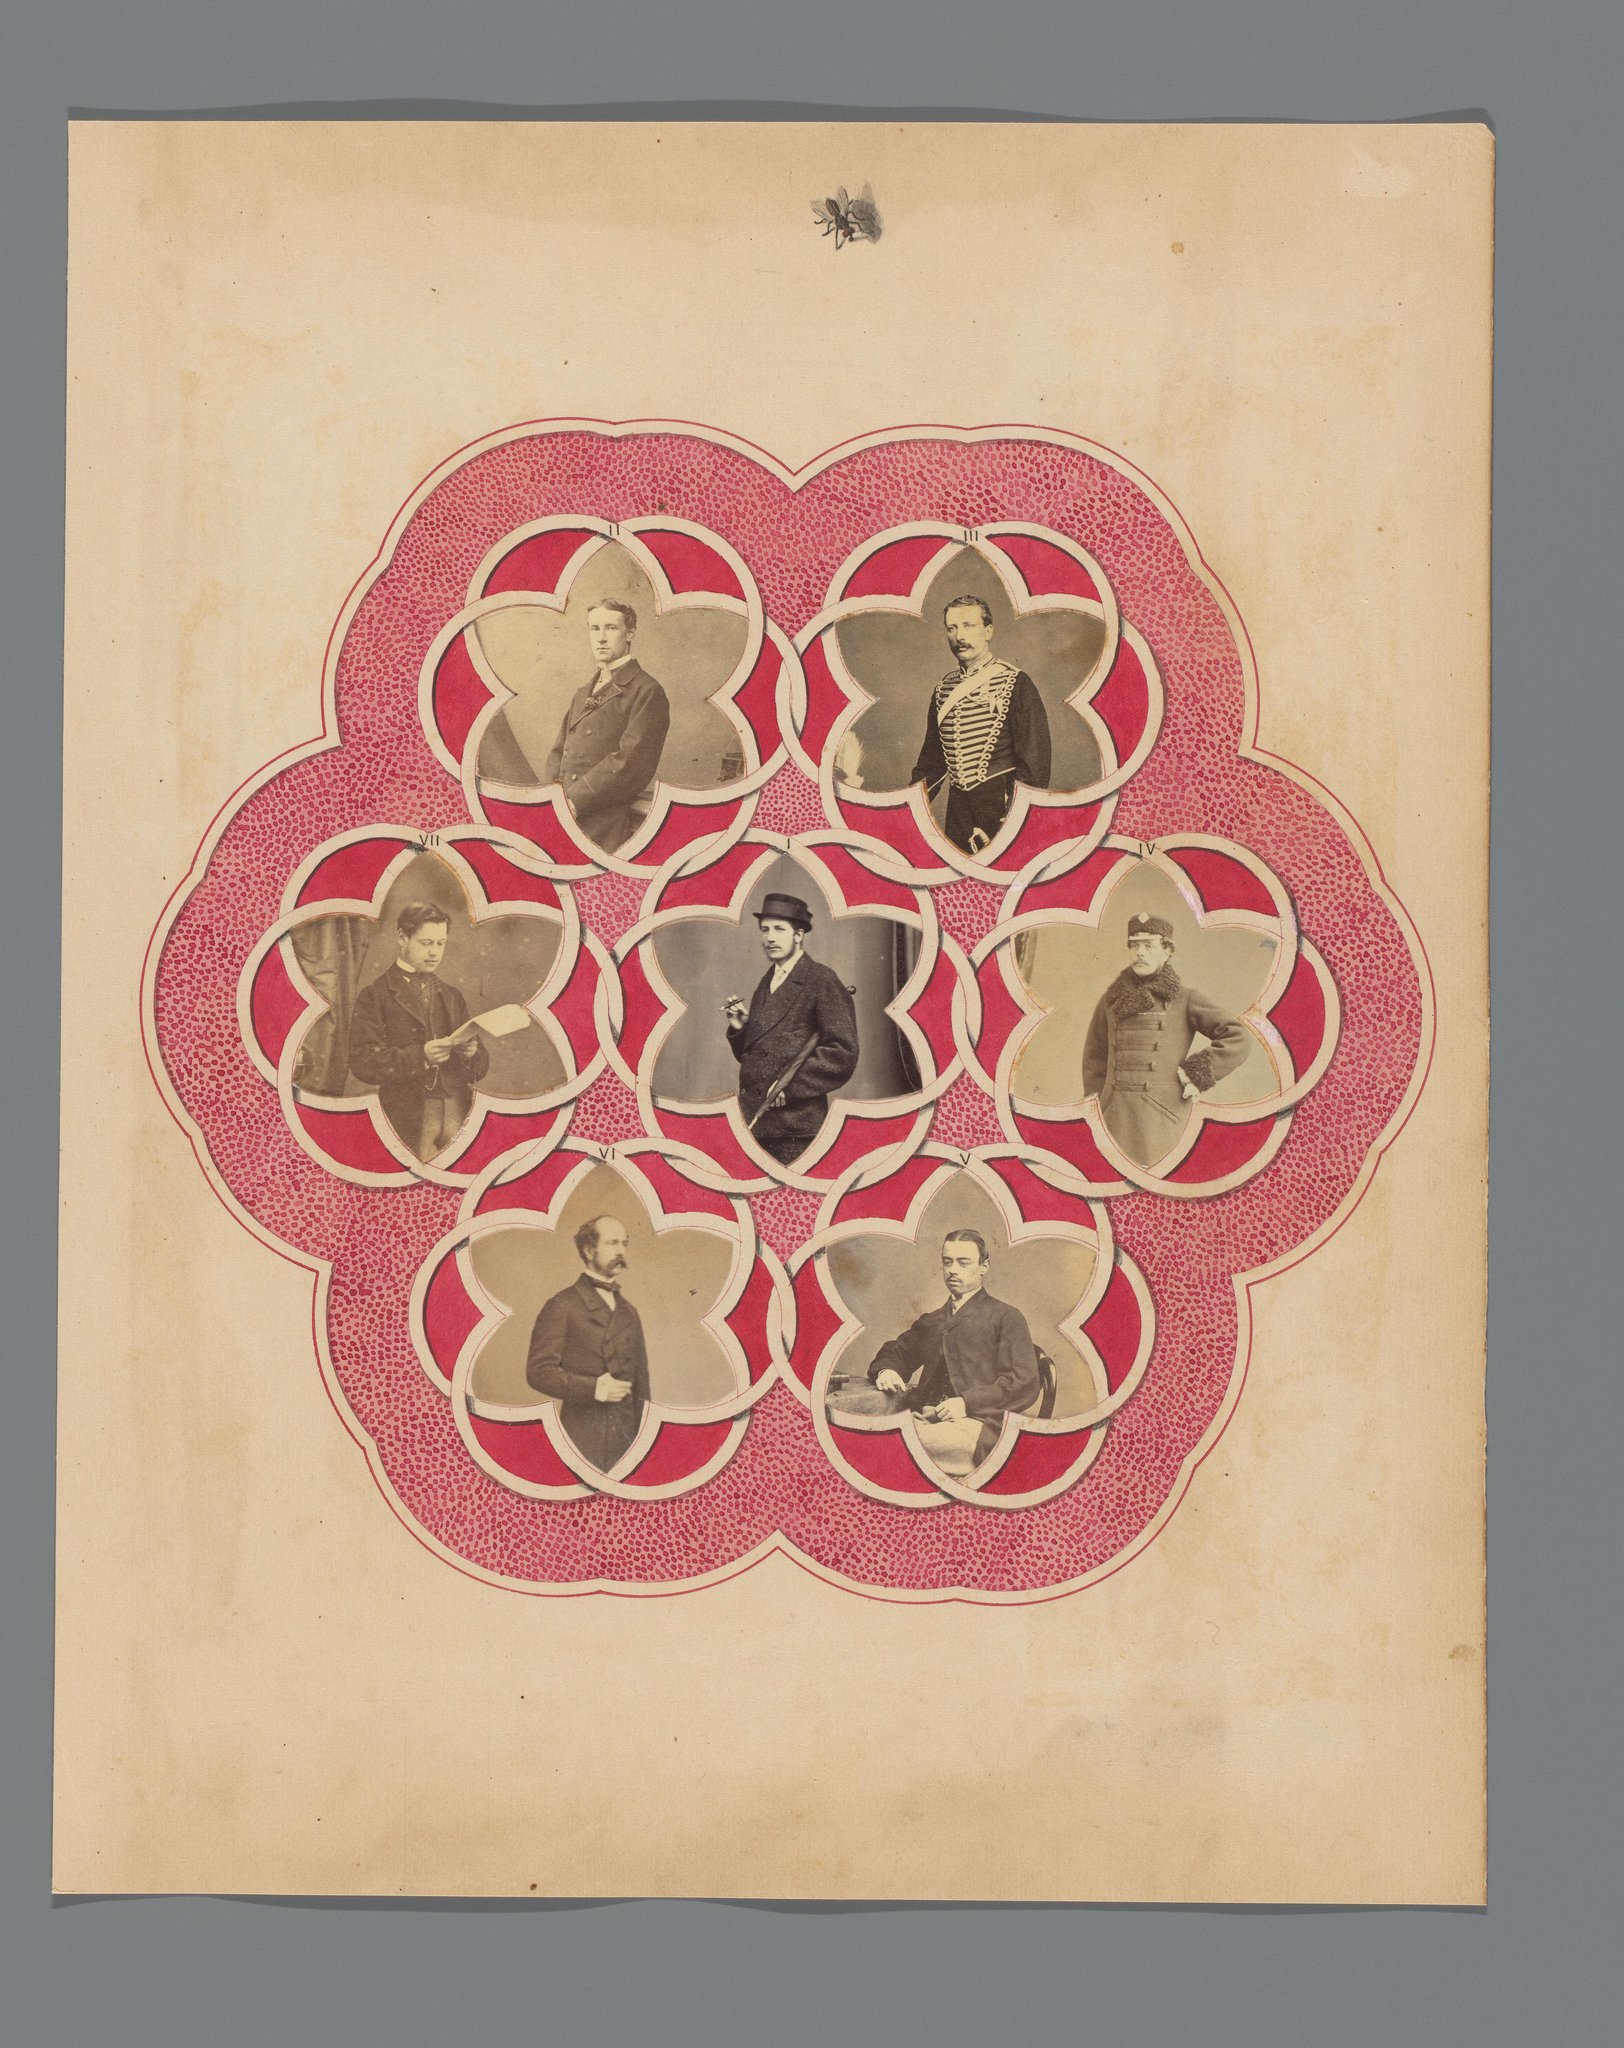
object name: panoramic photograph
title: Albumblad met 7 portretten, met randversiering in rode inkt en/of verf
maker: Anonymous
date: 1860-1875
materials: ink, paper, photographic support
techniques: albumen print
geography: united kingdom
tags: reims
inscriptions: inscription: ‘NATIVE SERVANTS IN BENGAL’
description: Verso lijmresten van een verwijderde foto, met daaronder in pen de namen en functies van de voorgestelden en de tekst 'NATIVE SERVANTS IN BENGAL'